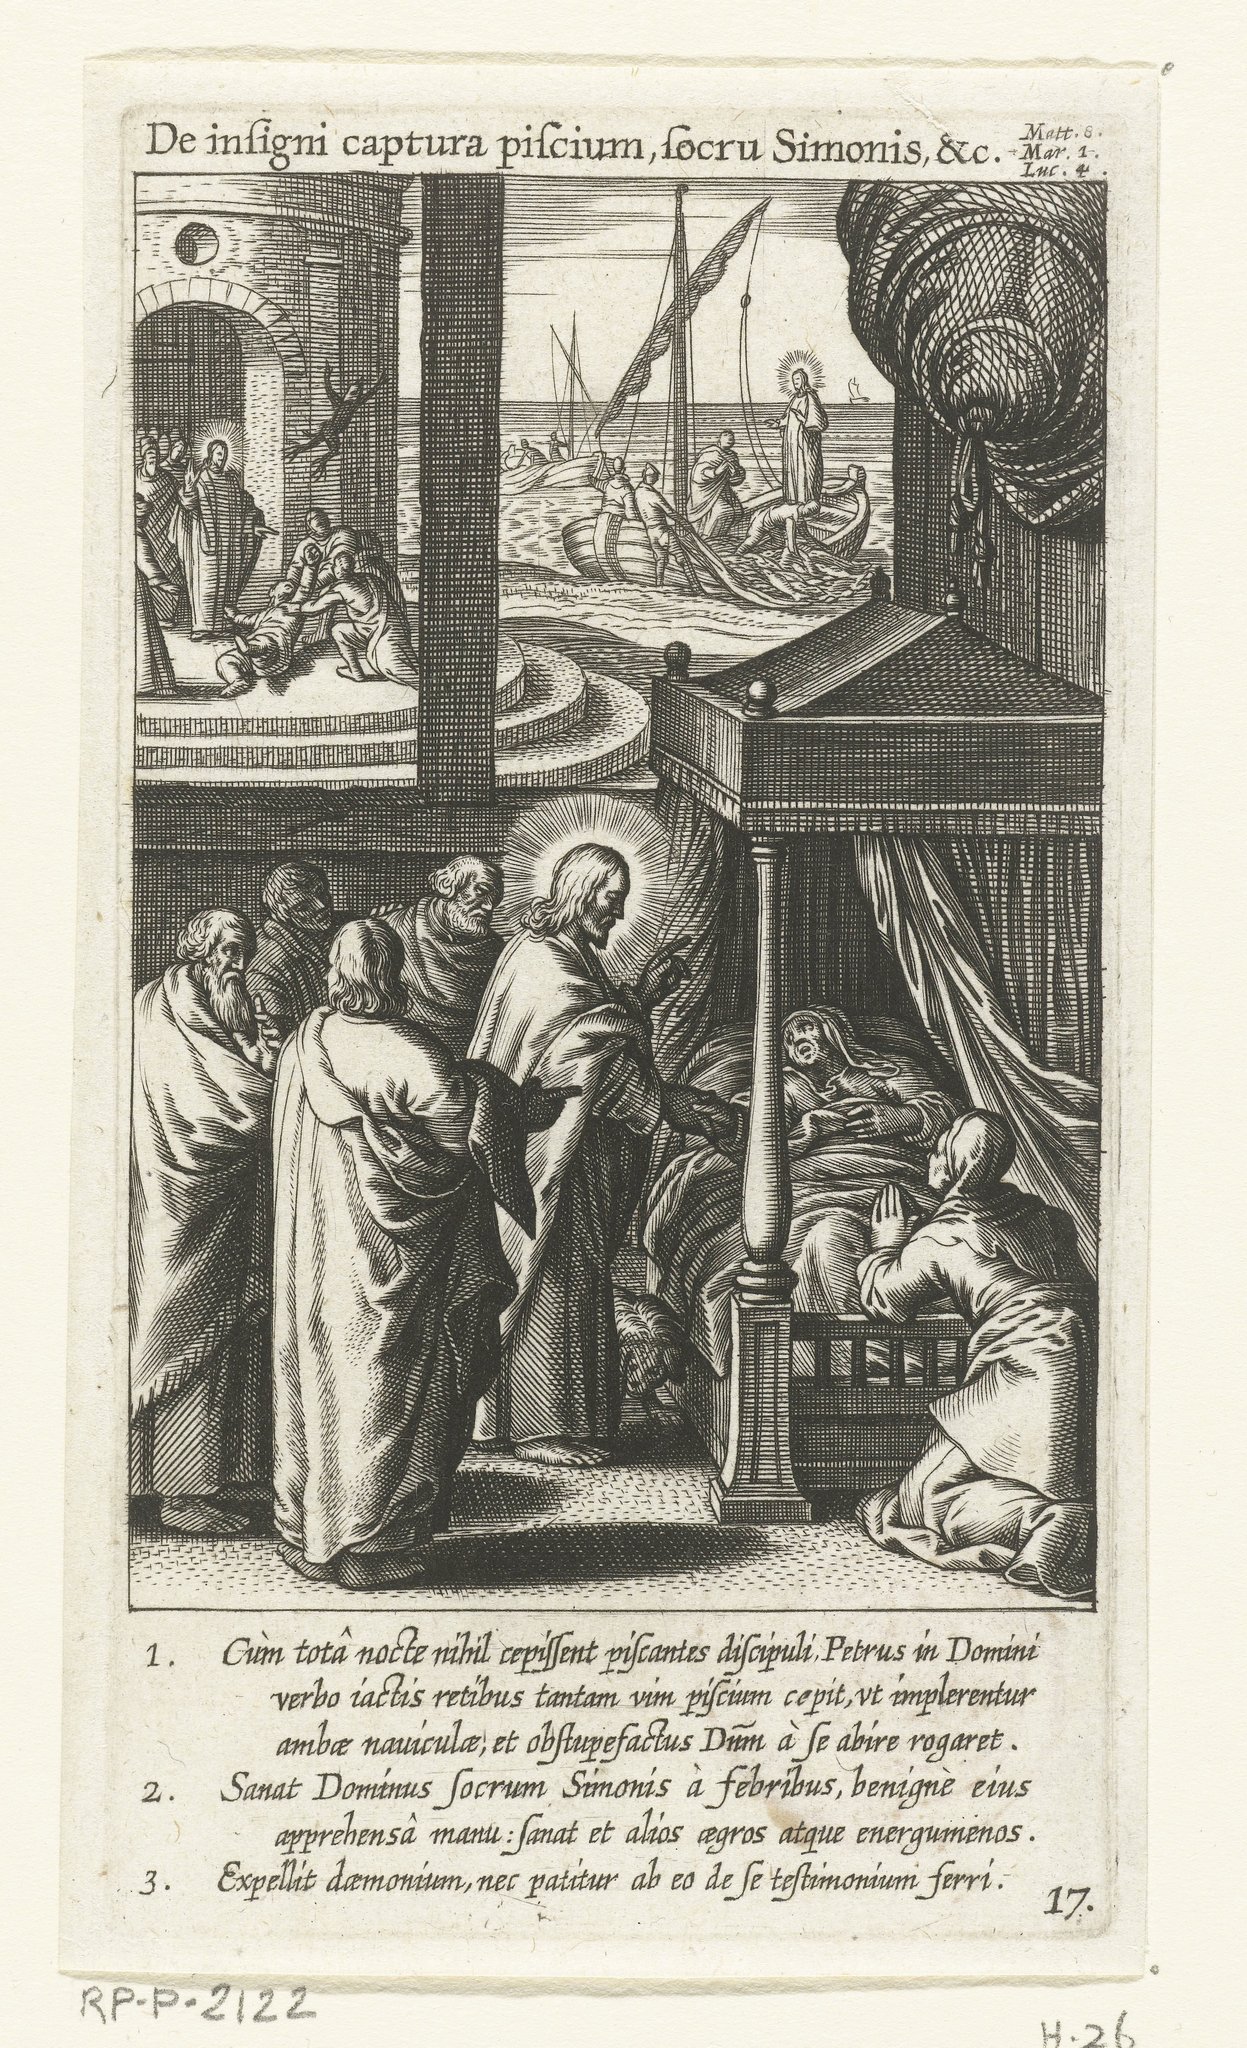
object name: print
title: Vitae passionis et mortis Jesu Christ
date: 1590-1622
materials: paper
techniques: engraving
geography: antwerp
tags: the miraculous draught of fishes (before the resurrection) on the lake of gennesaret (sea of galilee); james and john helping to bring in the nets (luke 5:1-11), miracles of christ ~ healing the sick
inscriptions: collector's mark: Lugt 240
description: Christus geneest een vrouw die ziek in bed ligt. In het landschap op de achtergrond zien we een duiveluitdrijving en de wonderbare visvangst.